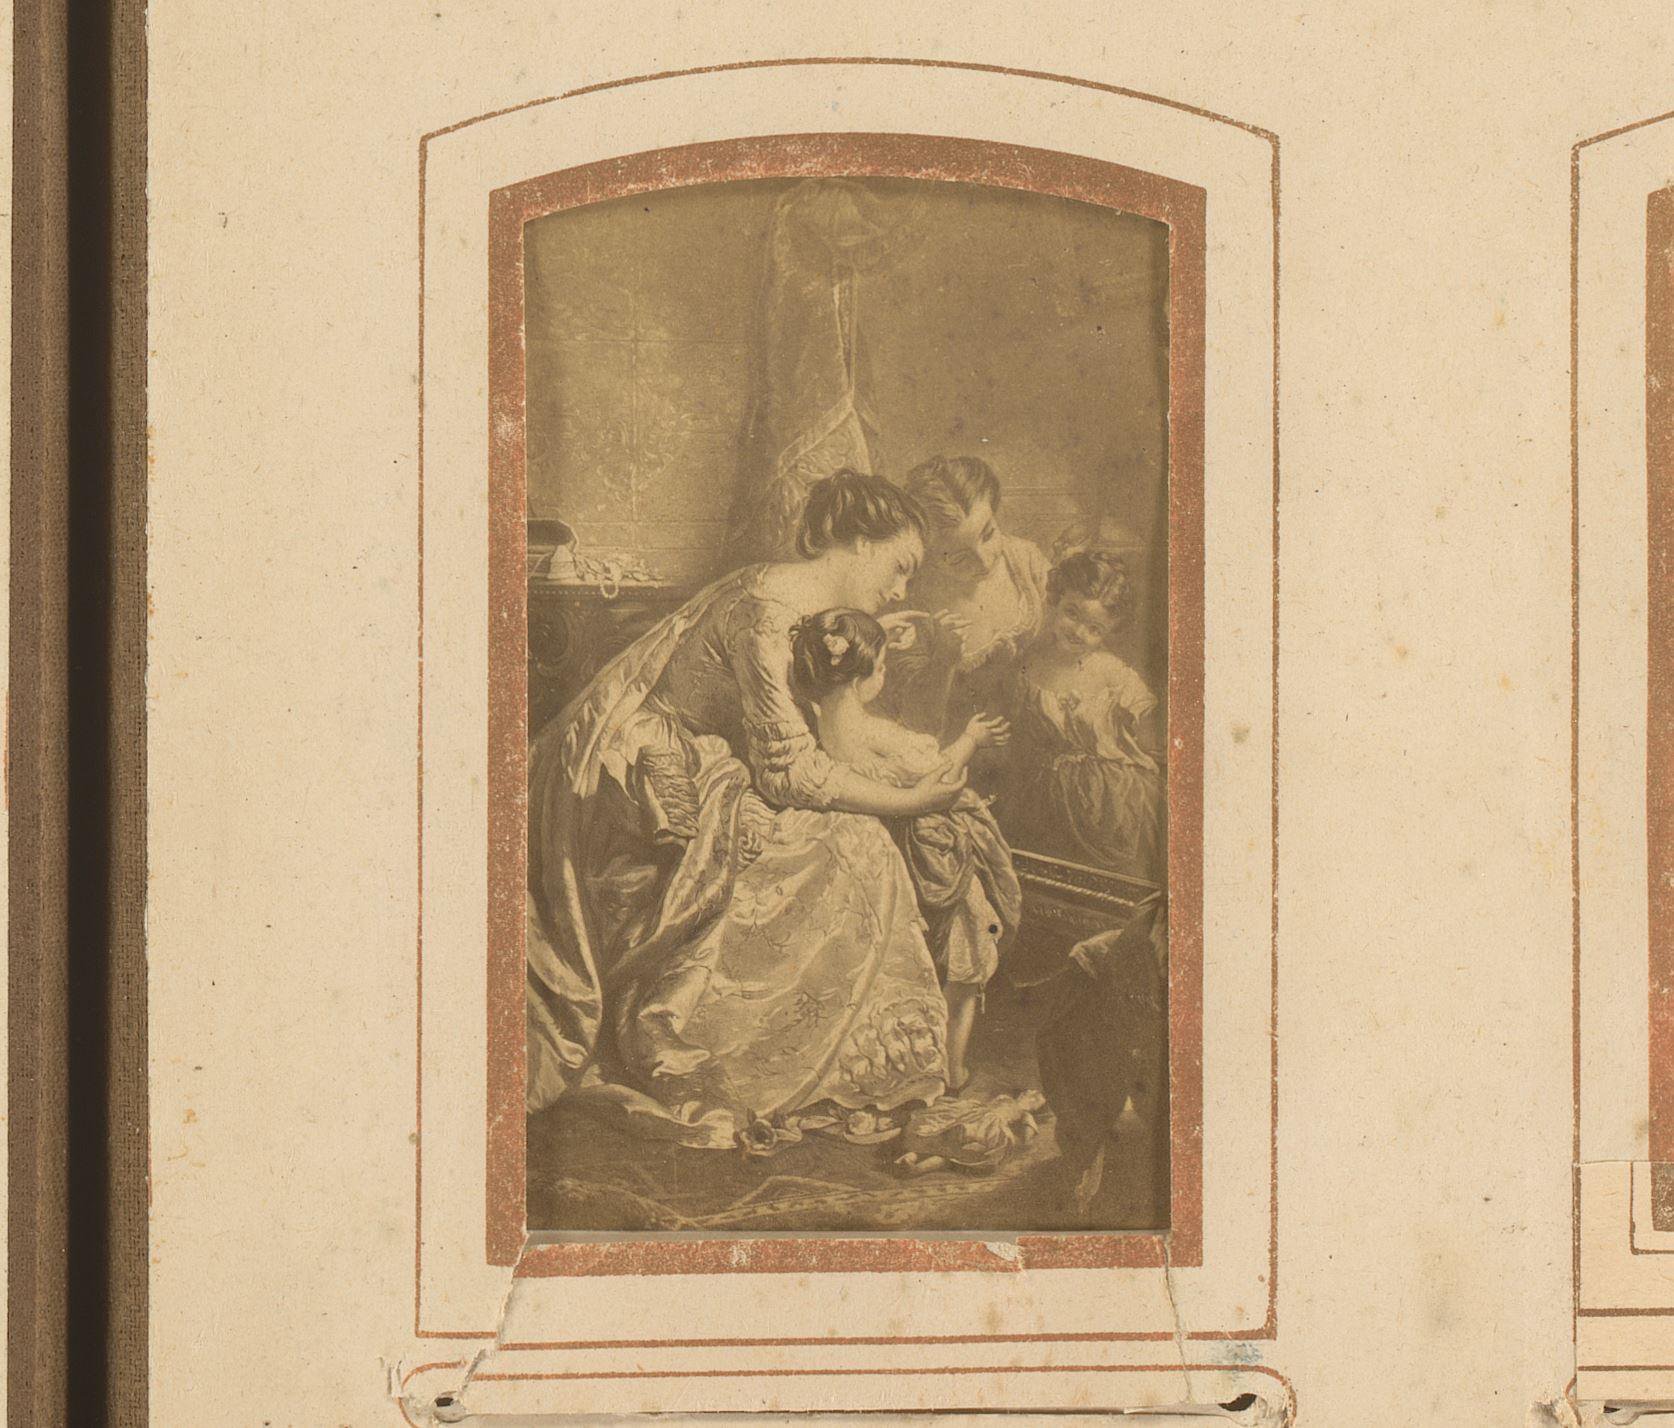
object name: carte de visite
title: Fotoreproductie van een schilderij van een vrouw en haar dochter voor de spiegel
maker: Anonymous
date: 1850-1900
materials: cardboard, photographic support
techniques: albumen print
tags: mother with daughter(s) (mother-love), mirror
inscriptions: inscription: ‘Nr. 330./ Mama's Bild./ Le portrait de maman./ Mamma's portrait.’